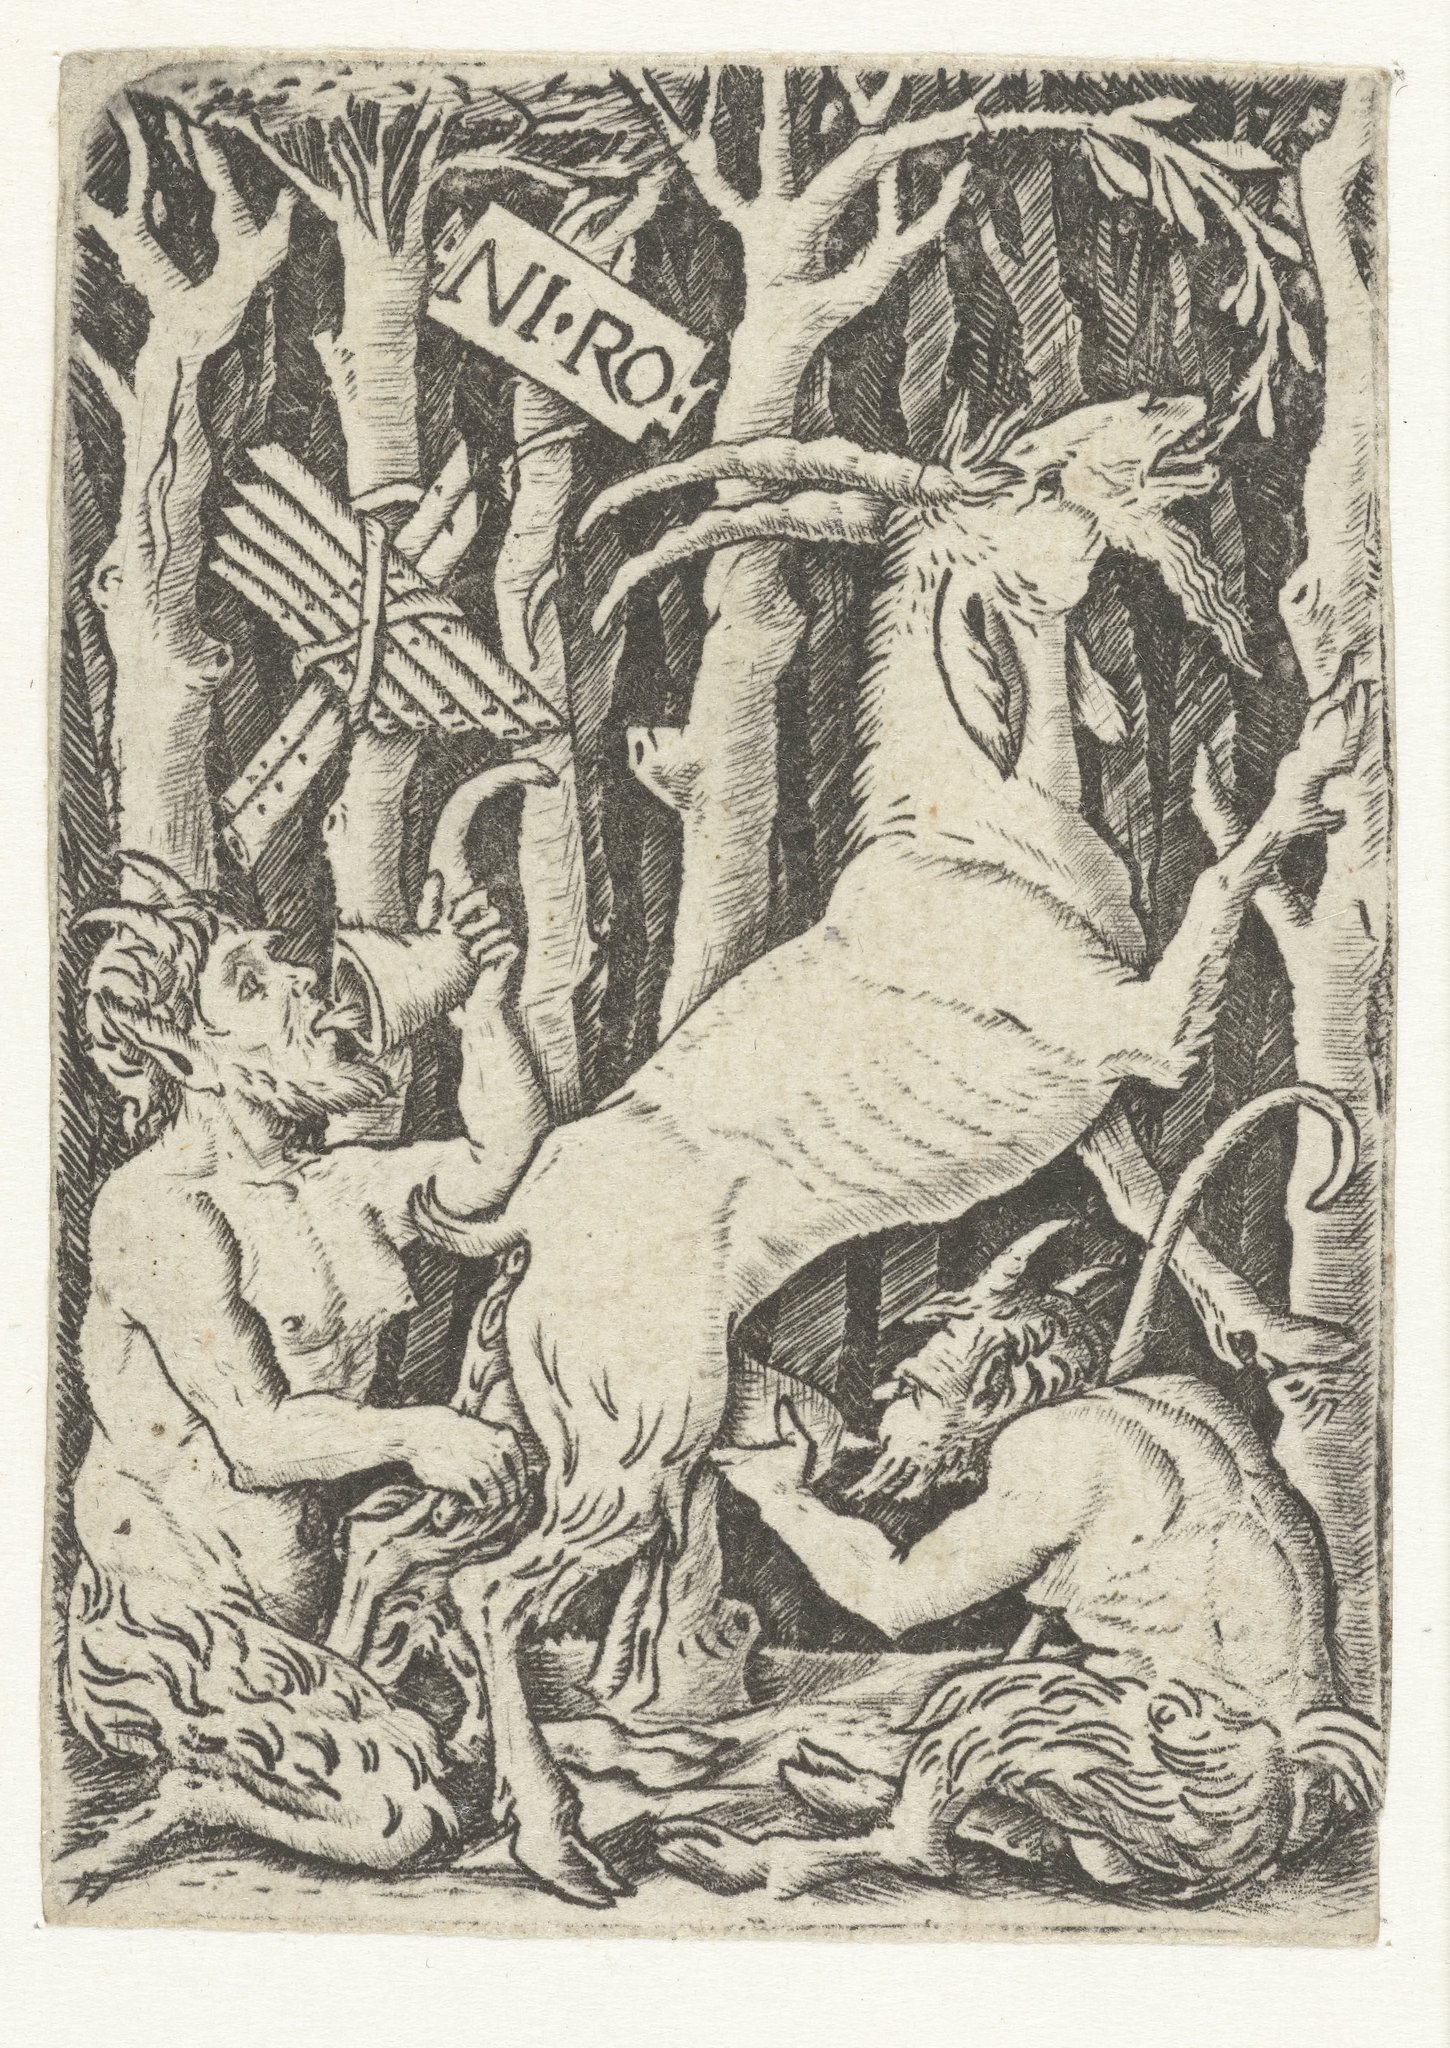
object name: print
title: Twee satyrs drinken melk van geit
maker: nicoletto da modena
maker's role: print maker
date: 1490-1520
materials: paper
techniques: engraving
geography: italy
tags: he-goat, billy-goat, satyr(s) (in general)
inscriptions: collector's mark: Lugt 240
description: Deze gravure imiteert de niellotechniek met de witte figuren en bomen die afsteken tegen de zwarte achtergrond.